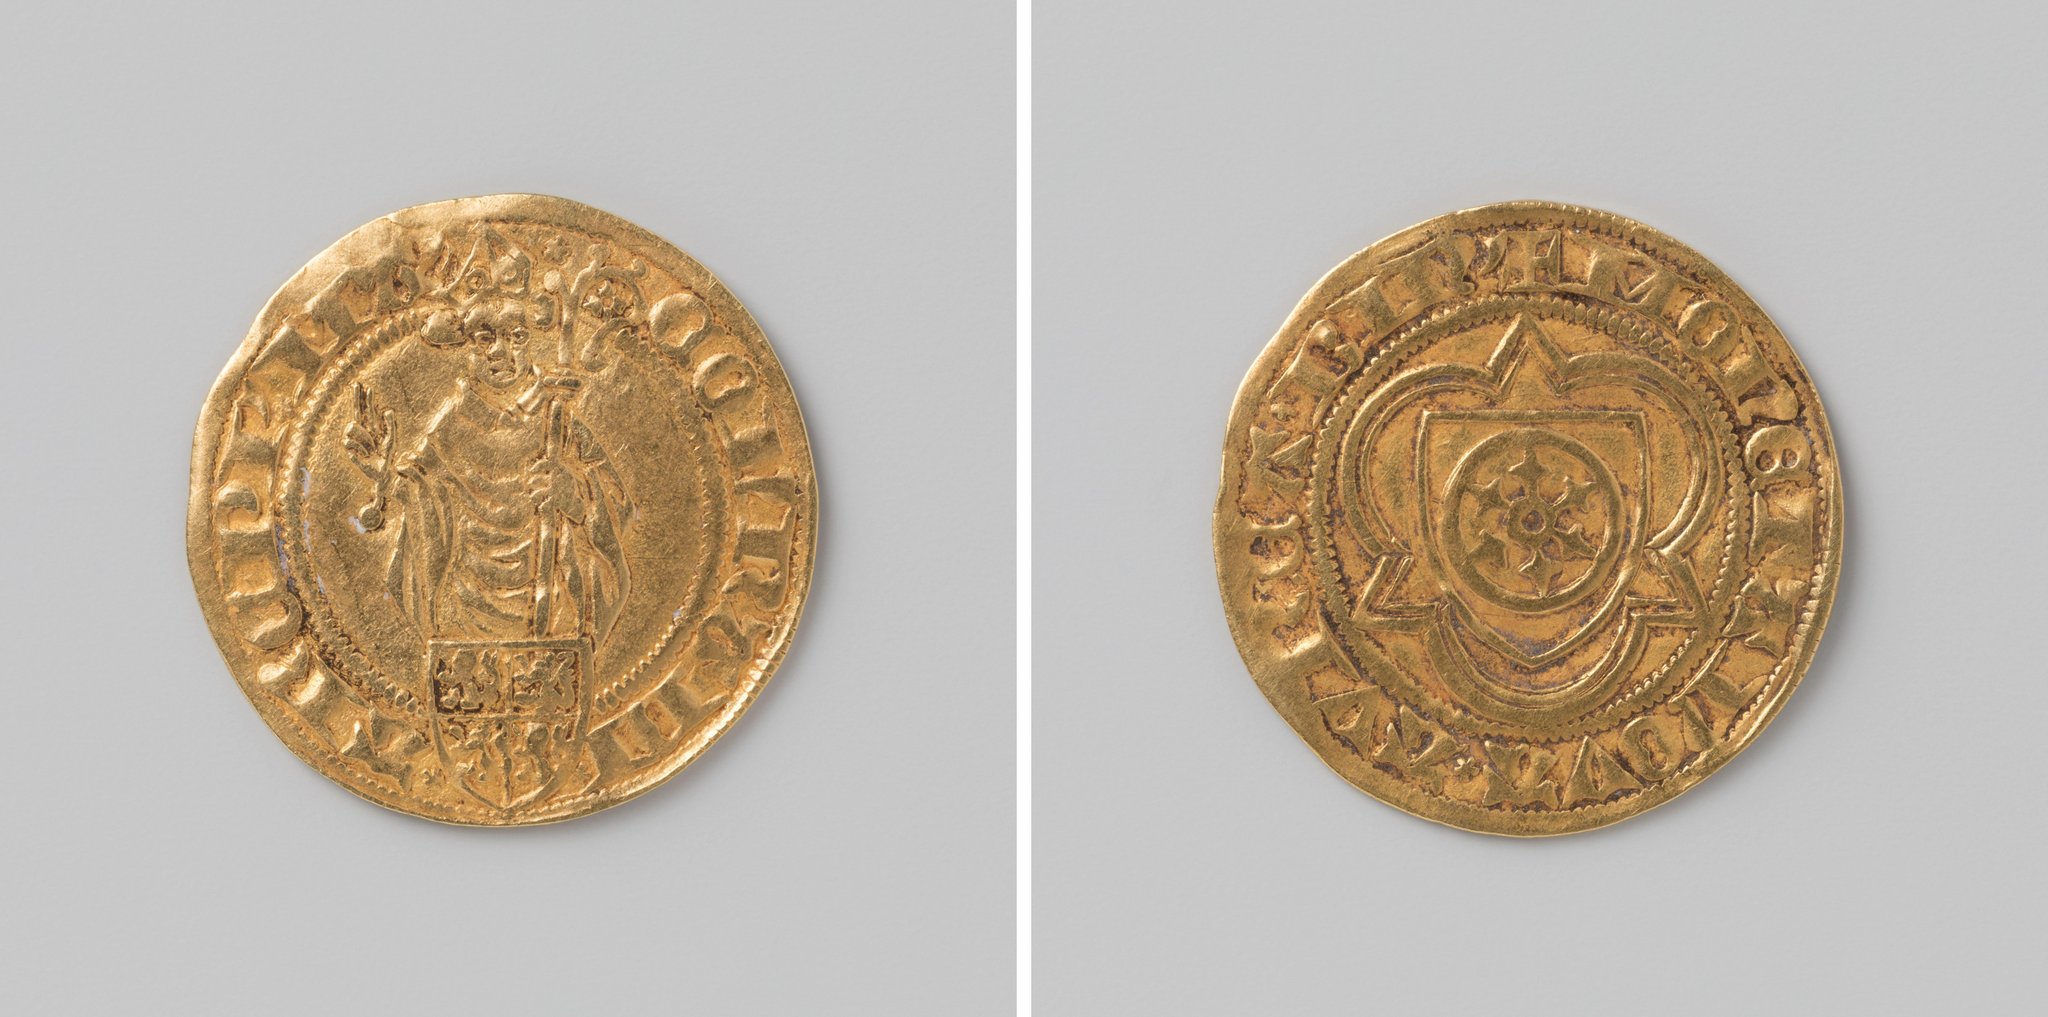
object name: coin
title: Rijnsgulden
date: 1430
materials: gold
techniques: striking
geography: bingen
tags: germany, brielle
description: Opgegraven in de tuin van het in 1557 gestichte Merula-weeshuis te Brielle.